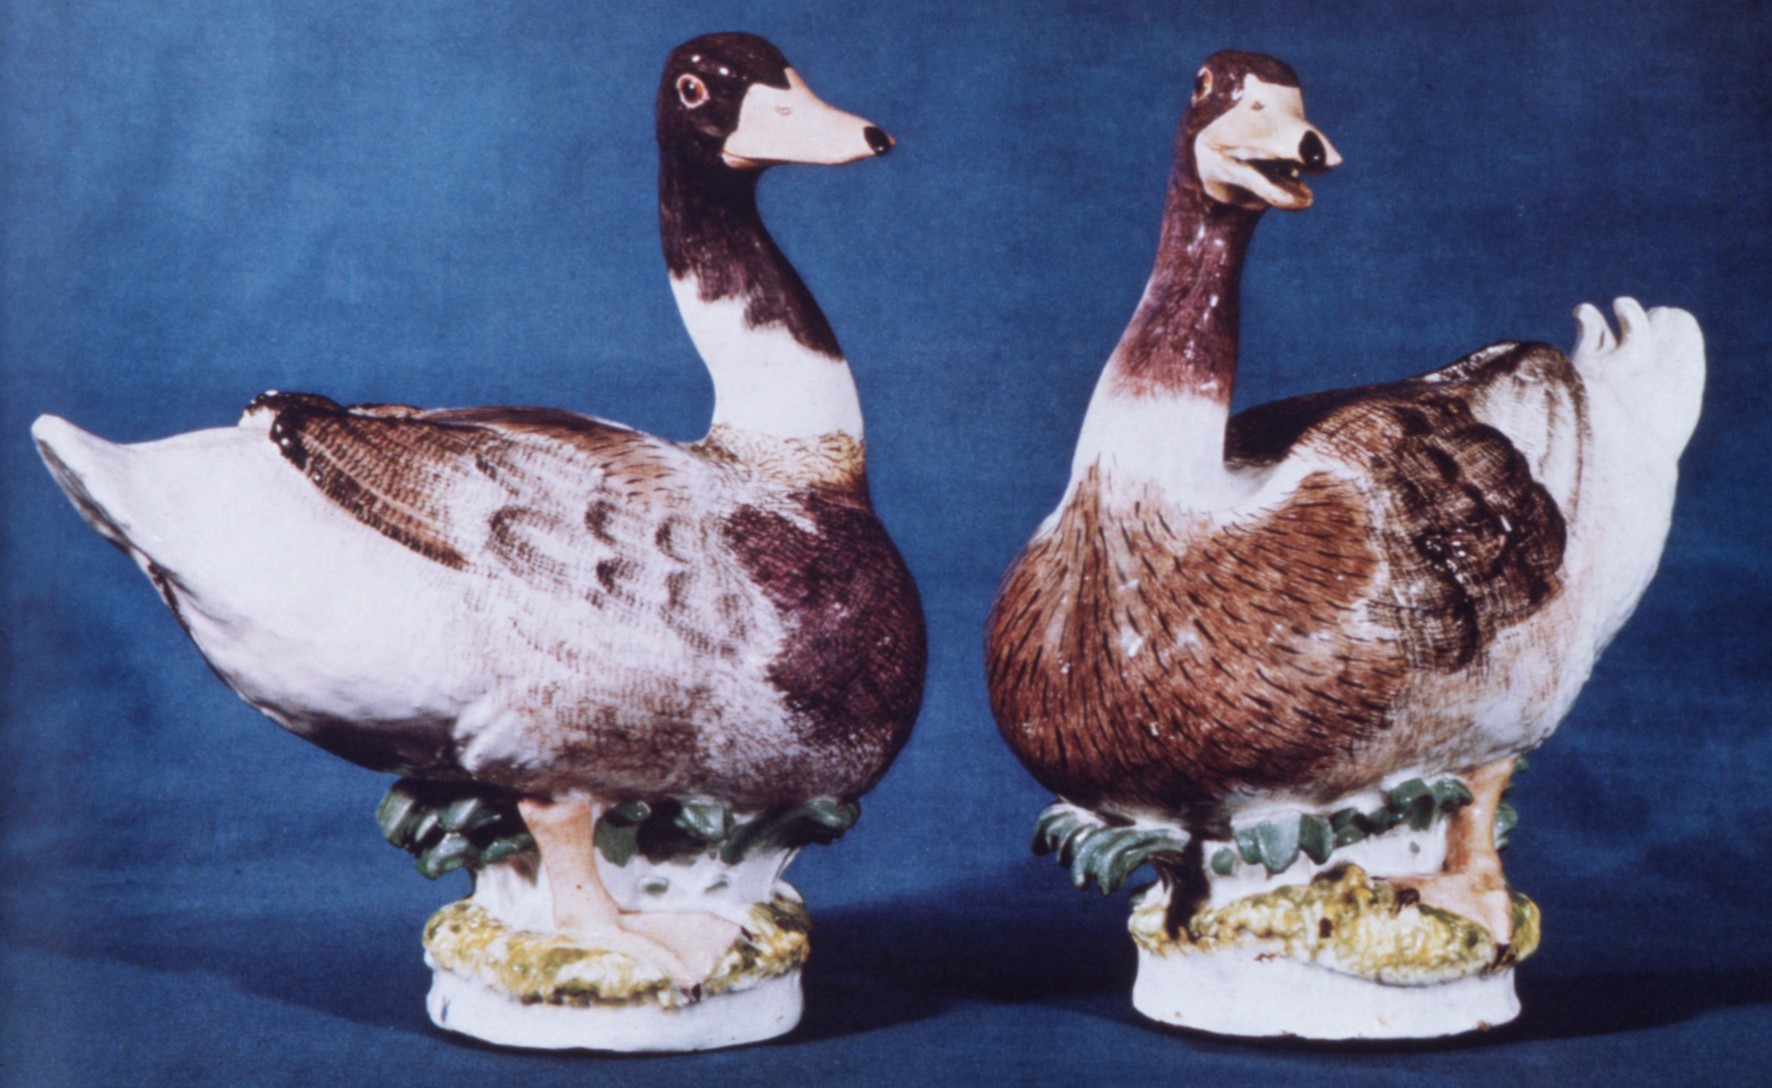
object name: figure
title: Mallard duck (one of a pair)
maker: meissen manufactory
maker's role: manufactory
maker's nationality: german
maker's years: 1710-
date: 1750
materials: hard paste porcelain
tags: ducks